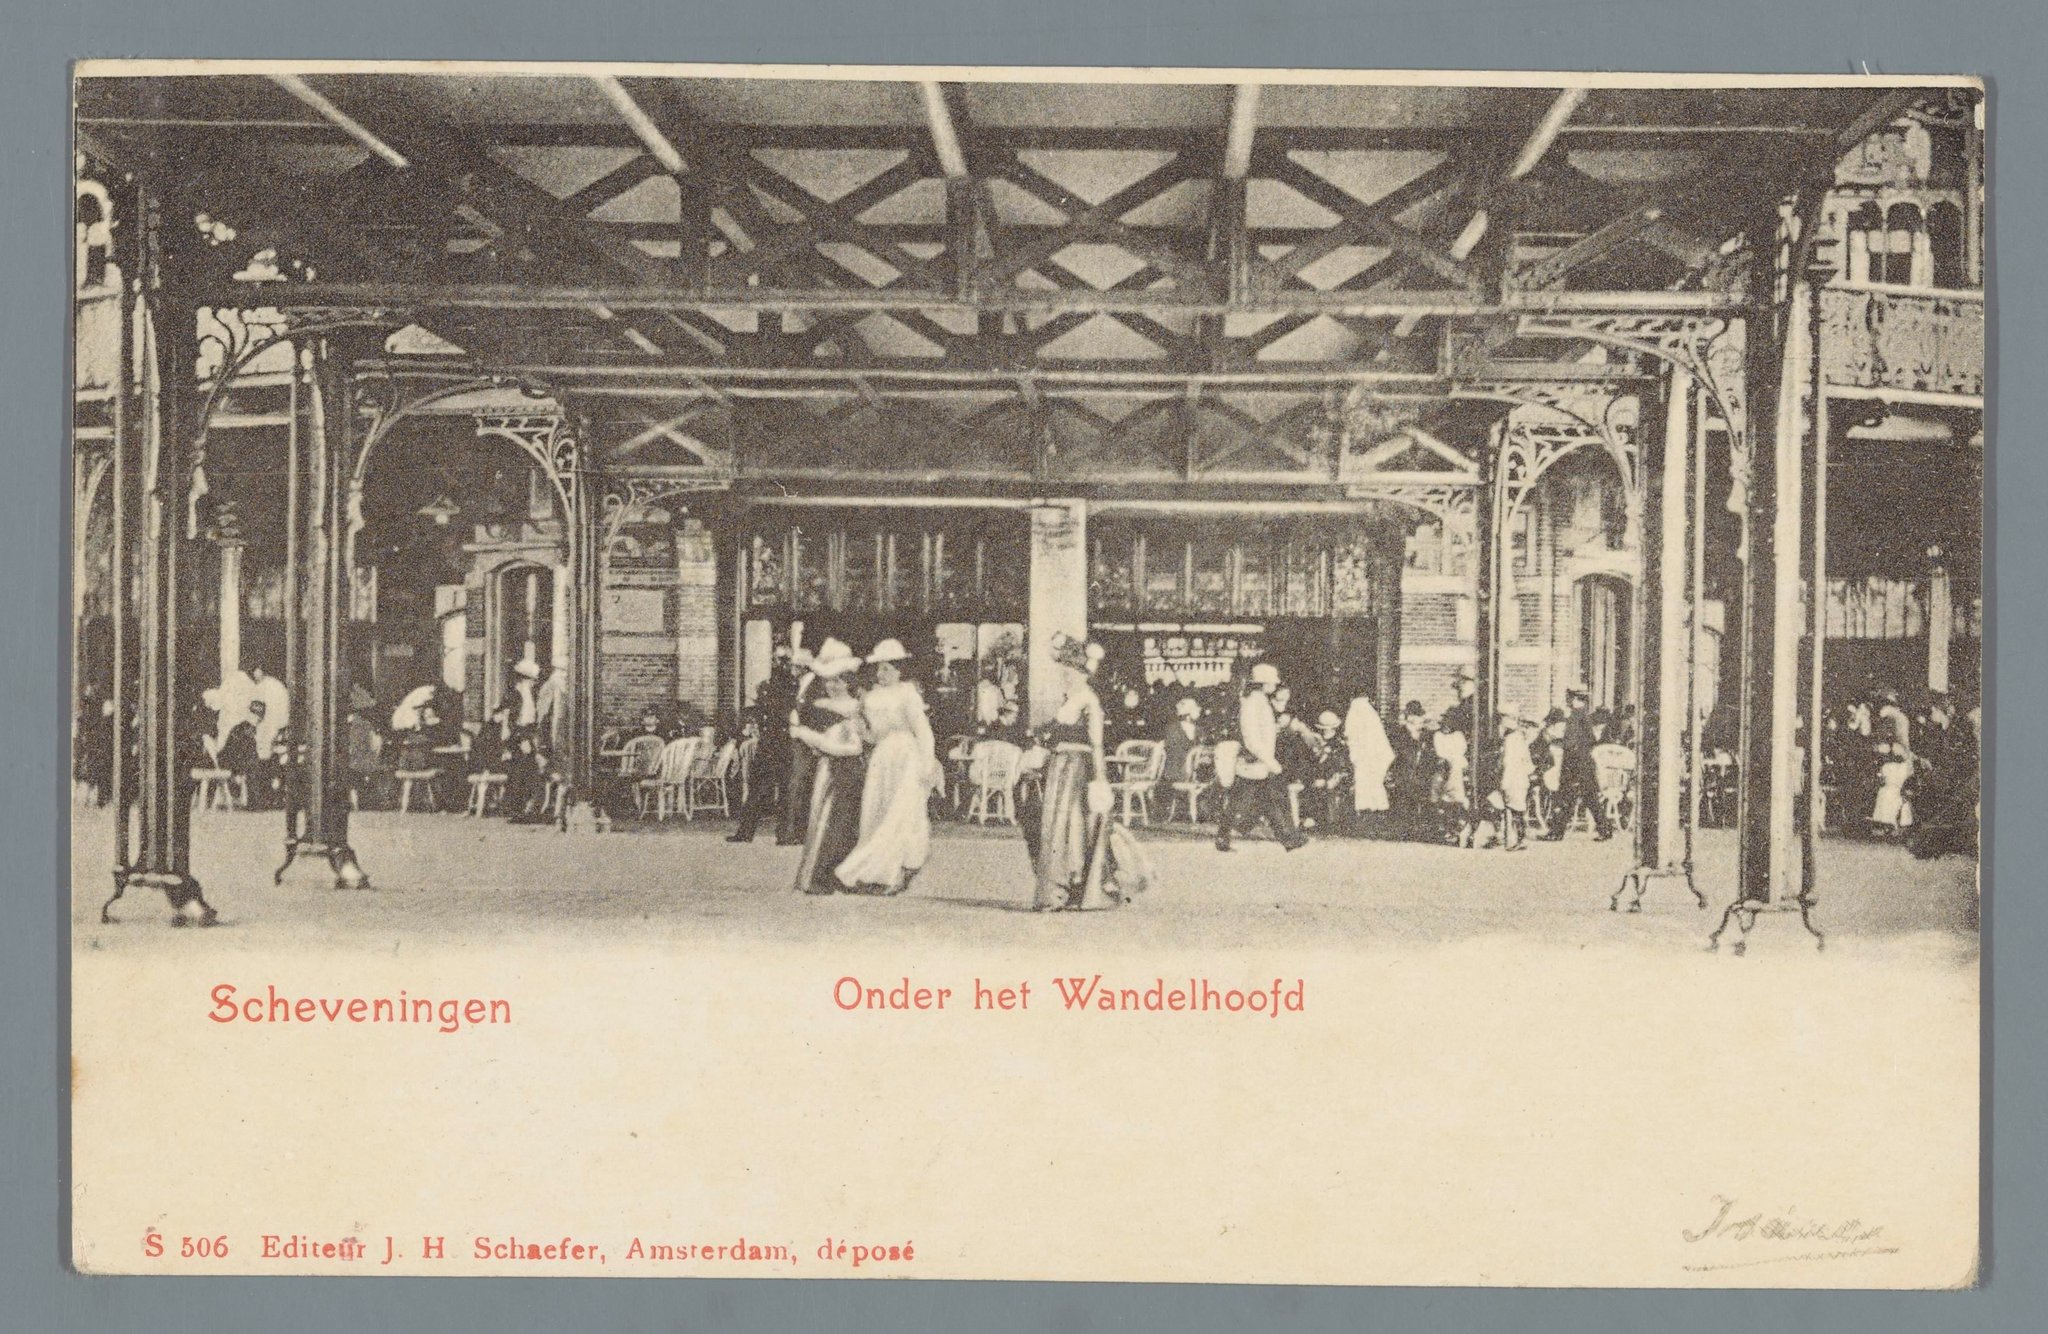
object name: photograph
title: Scheveningen, Onder het Wandelhoofd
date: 1902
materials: cardboard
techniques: photograph, writing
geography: scheveningen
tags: pier, quay, wharf